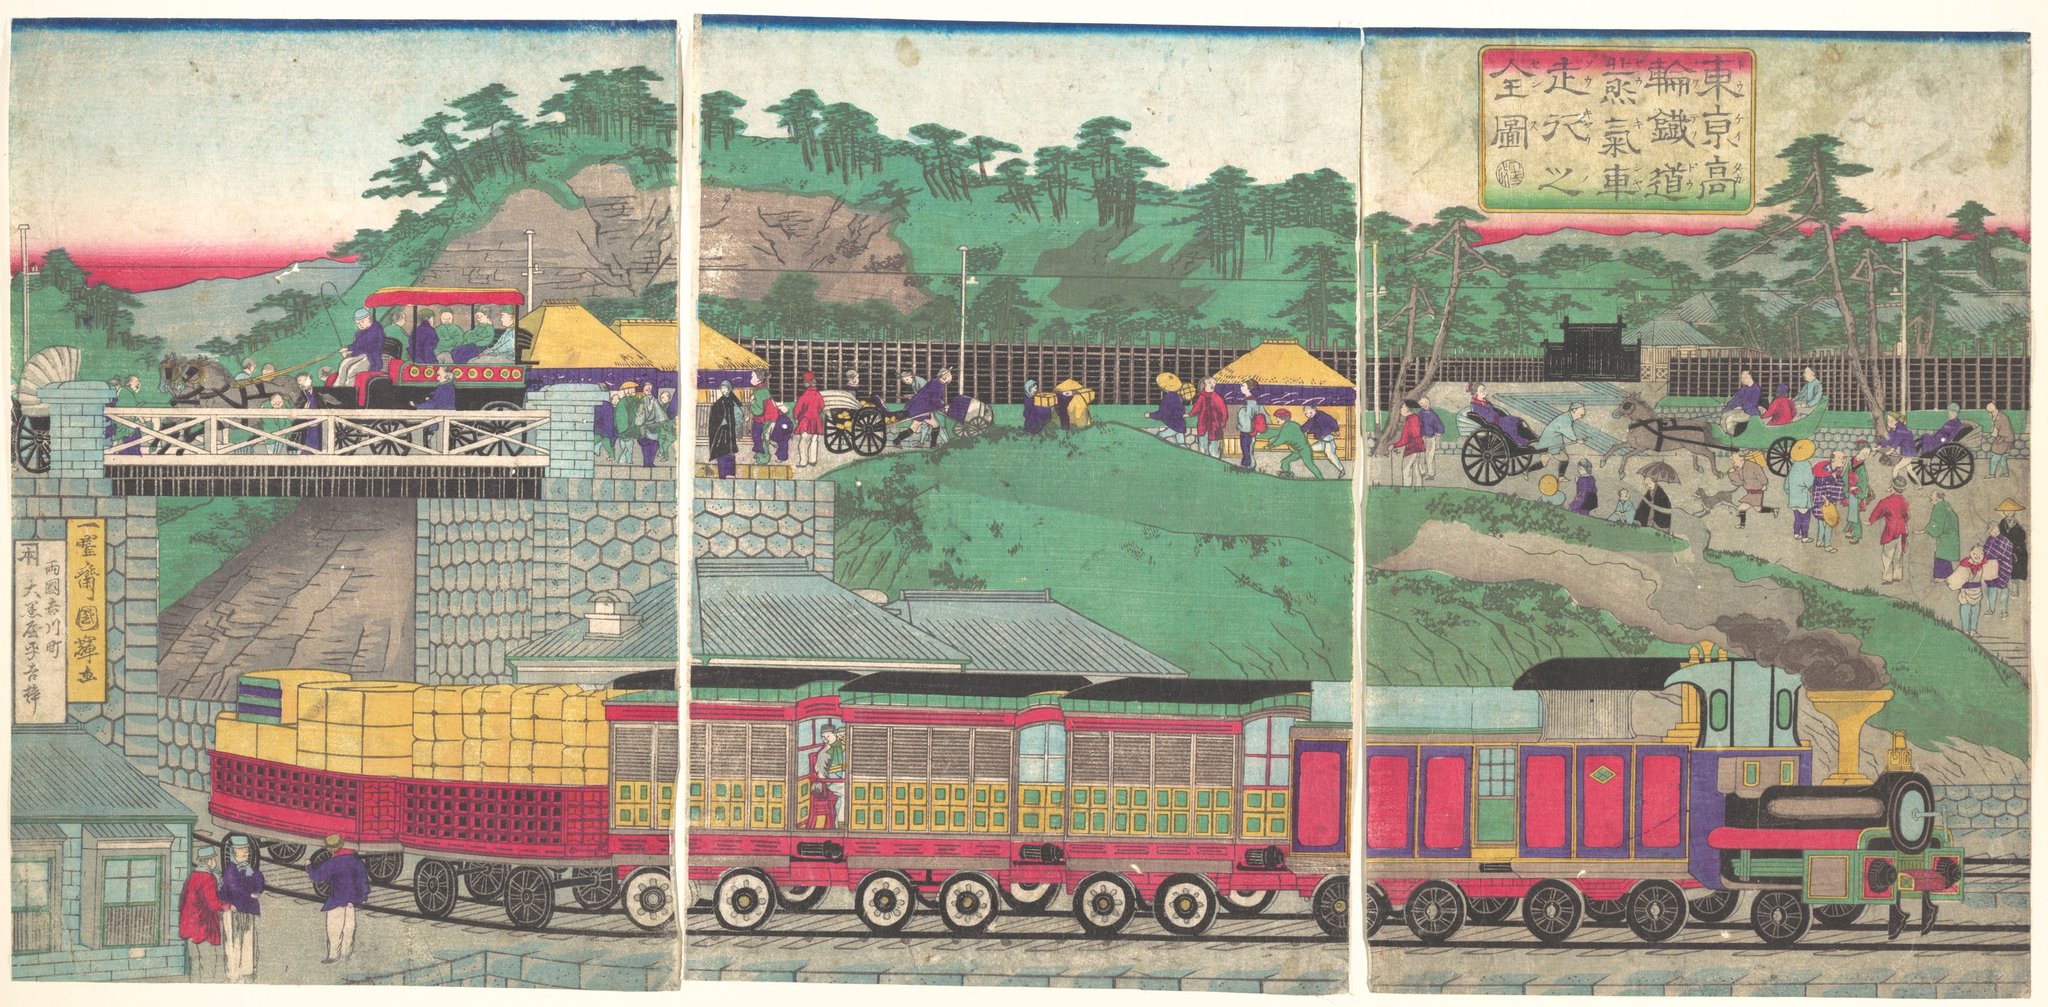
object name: print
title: Illustration of a Steam Locomotive Running on the Takanawa Railroad in Tokyo (Tōkyō takanawa tetsudō jōkisha sōkō no zu)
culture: japanese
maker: utagawa kuniteru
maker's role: artist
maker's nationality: japanese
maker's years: 1830-1874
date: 1873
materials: ink, paper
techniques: woodblock print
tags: bridges,railways,hills,trains